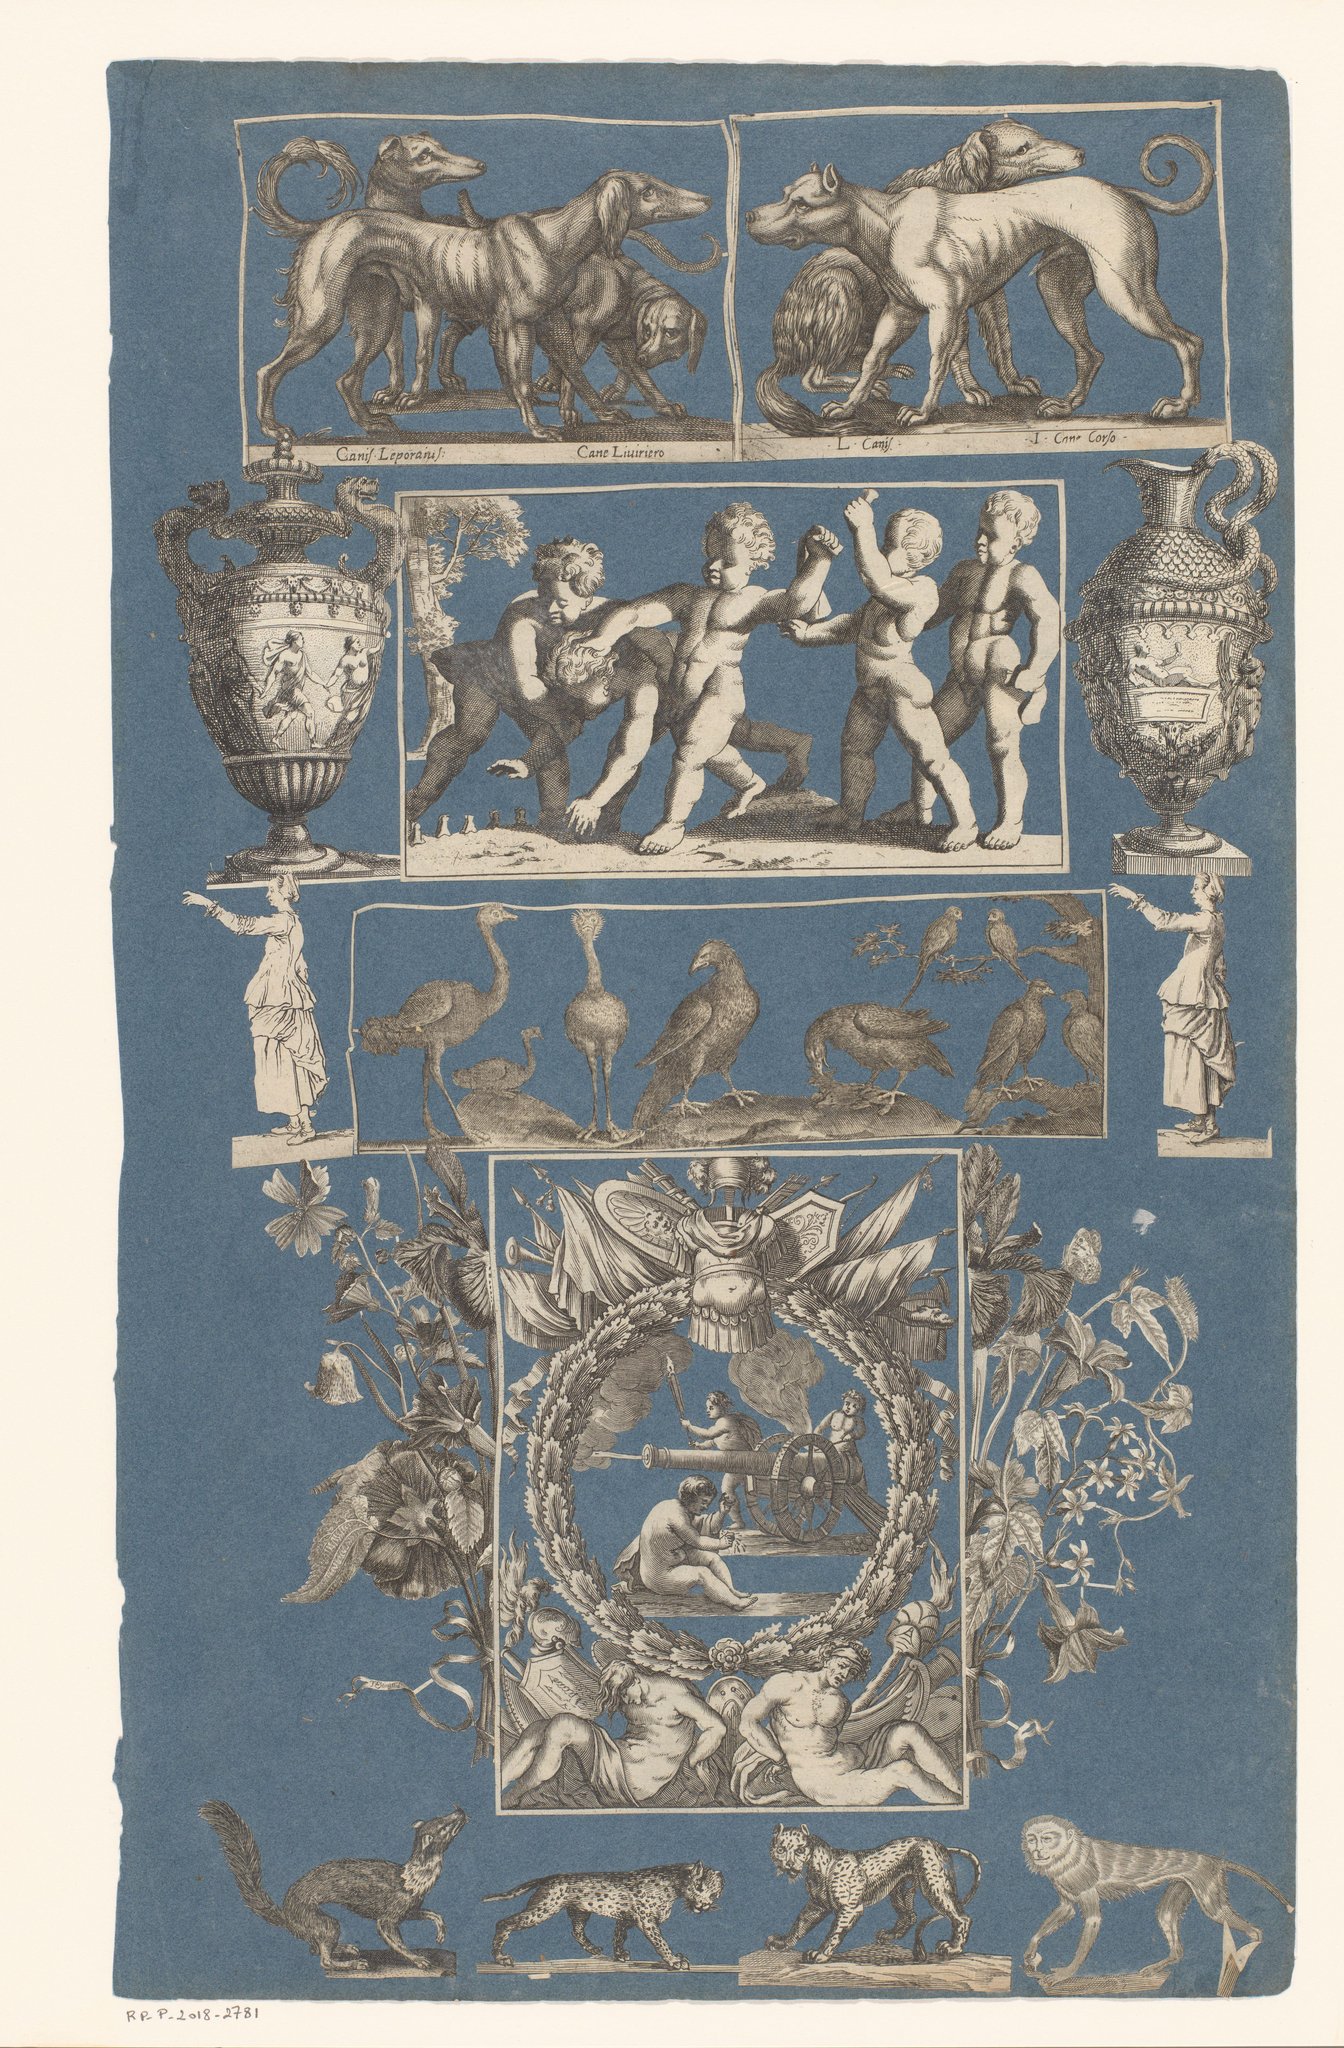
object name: print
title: Collage van uitgeknipte prenten geplakt op een albumblad van blauw papier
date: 1680-1720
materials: paper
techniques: engraving, etching, snipping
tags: 'tropaion', i.e. decorative ornament ~ weapons, dog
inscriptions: collector's mark: Lugt 2760, collector's mark: Lugt 2228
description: Blauw albumblad beplakt met uitgeknipte prenten van verschillende prentmakers en ontwerpers.